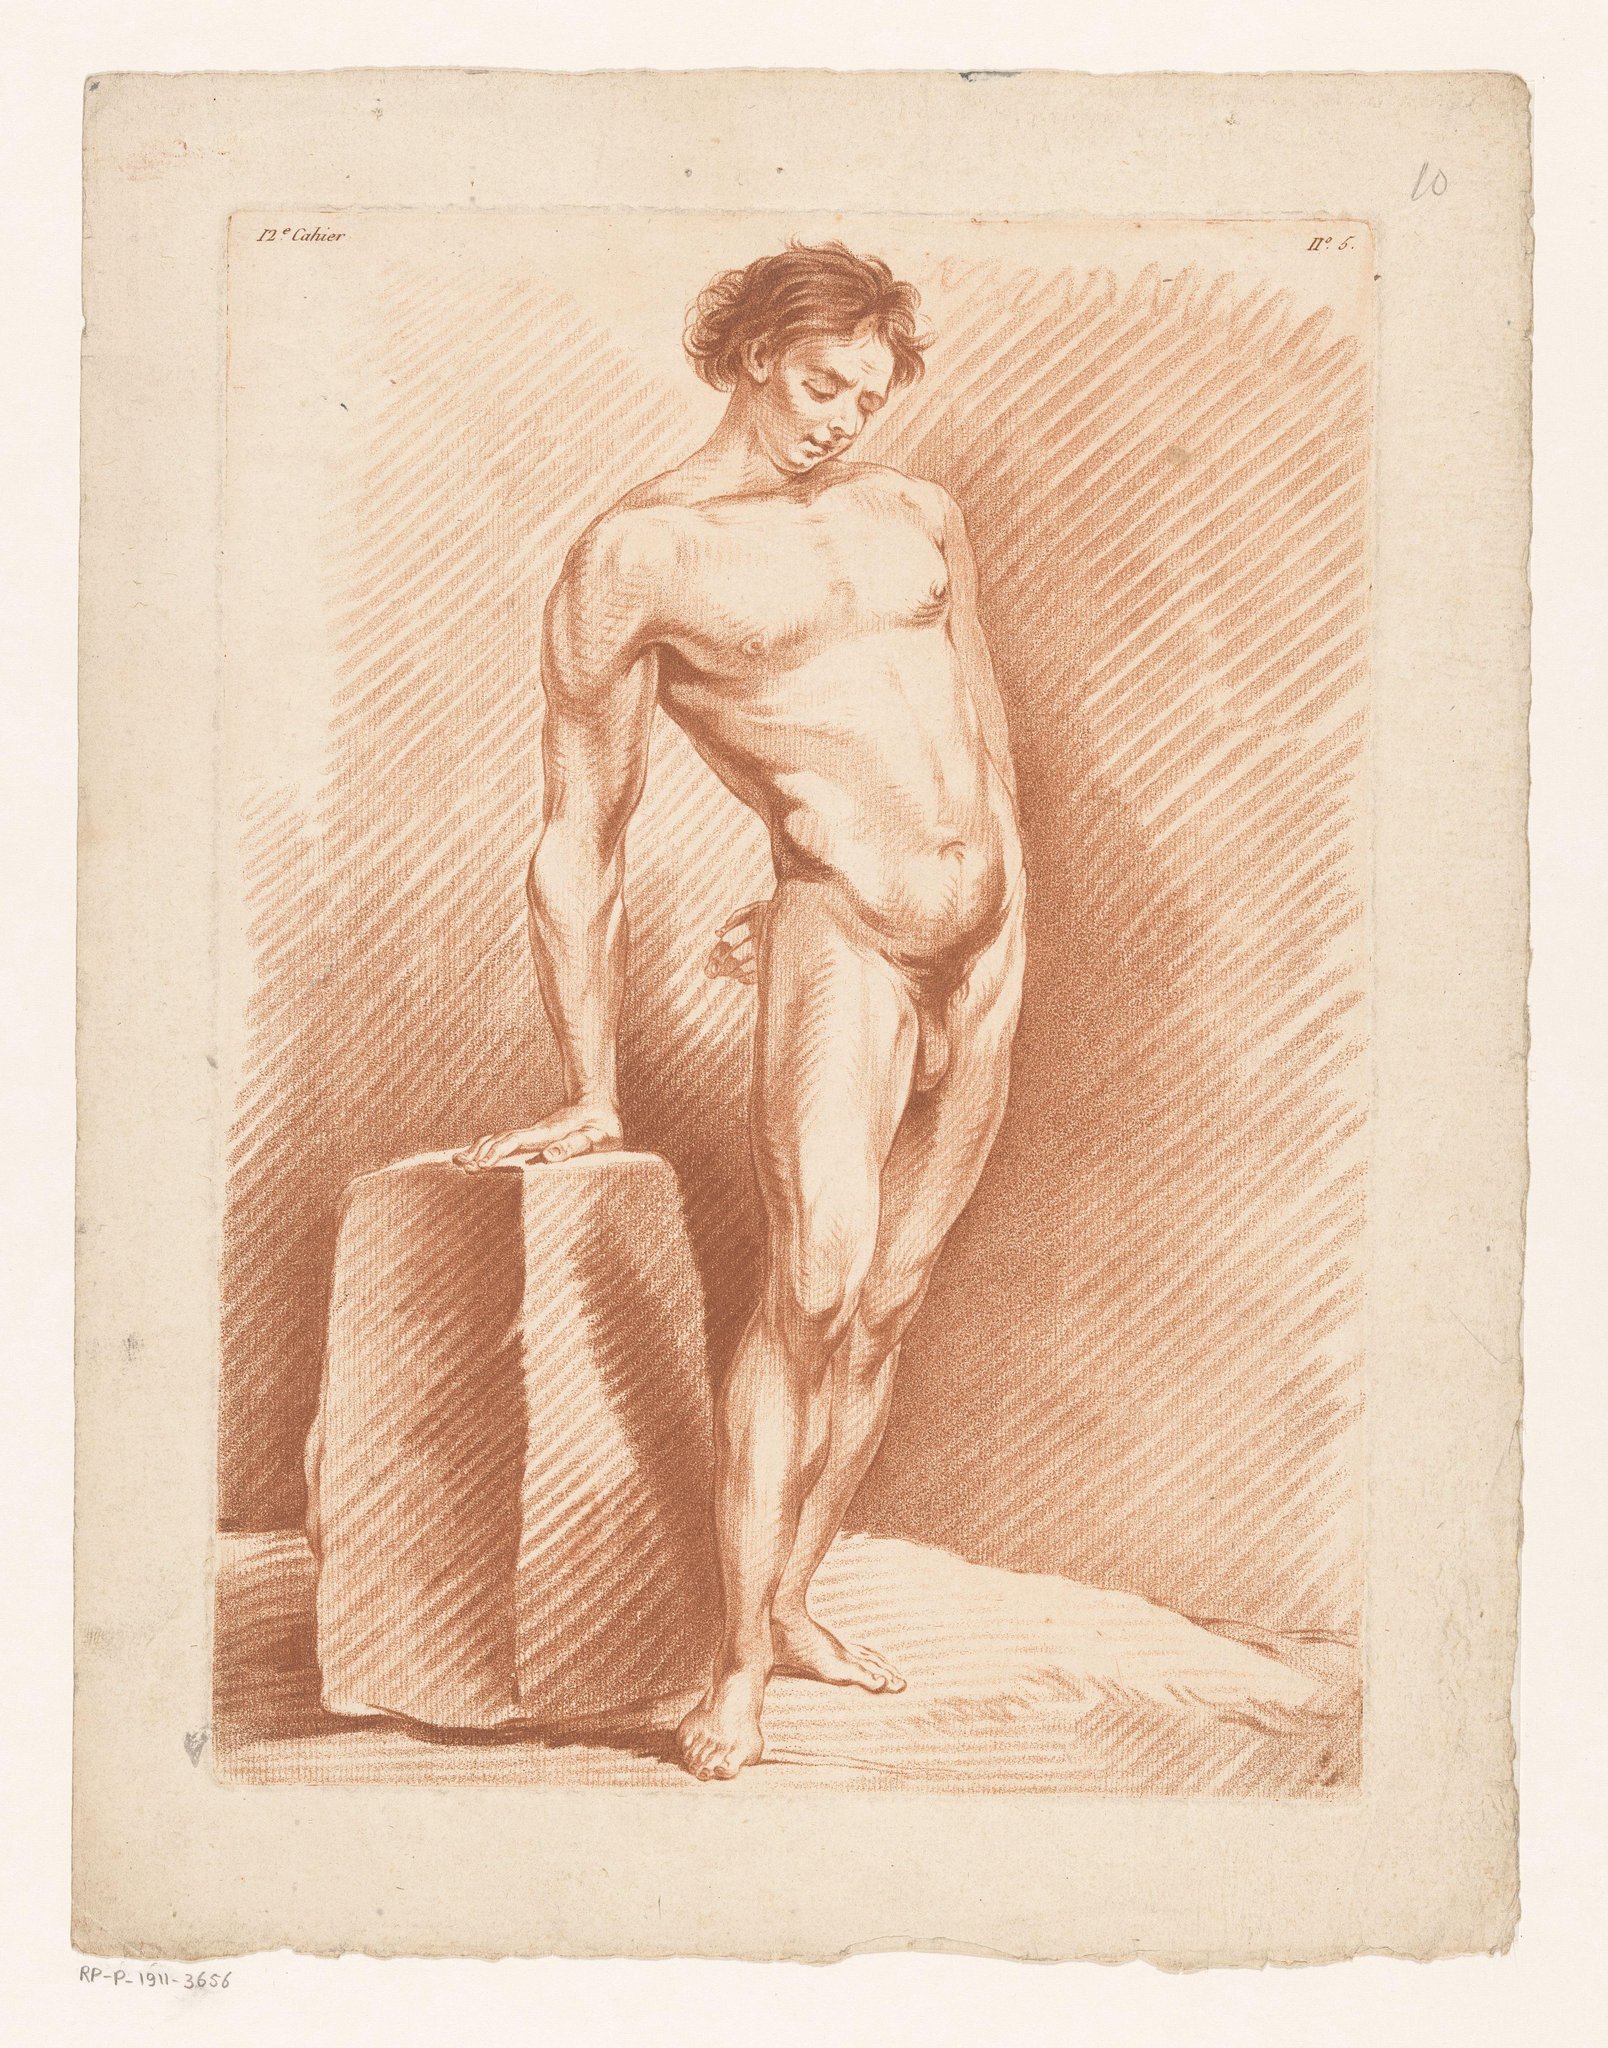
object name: print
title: Mannelijk naakt naast een blok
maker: louis marin bonnet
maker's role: print maker, publisher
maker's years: 1736-1793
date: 1746-1793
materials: paper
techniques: printmaking, etching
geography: france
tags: the (nude) human figure; 'corpo humano' (ripa), man (showing himself) undressed, quasi-nude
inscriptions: collector's mark: Lugt 2228